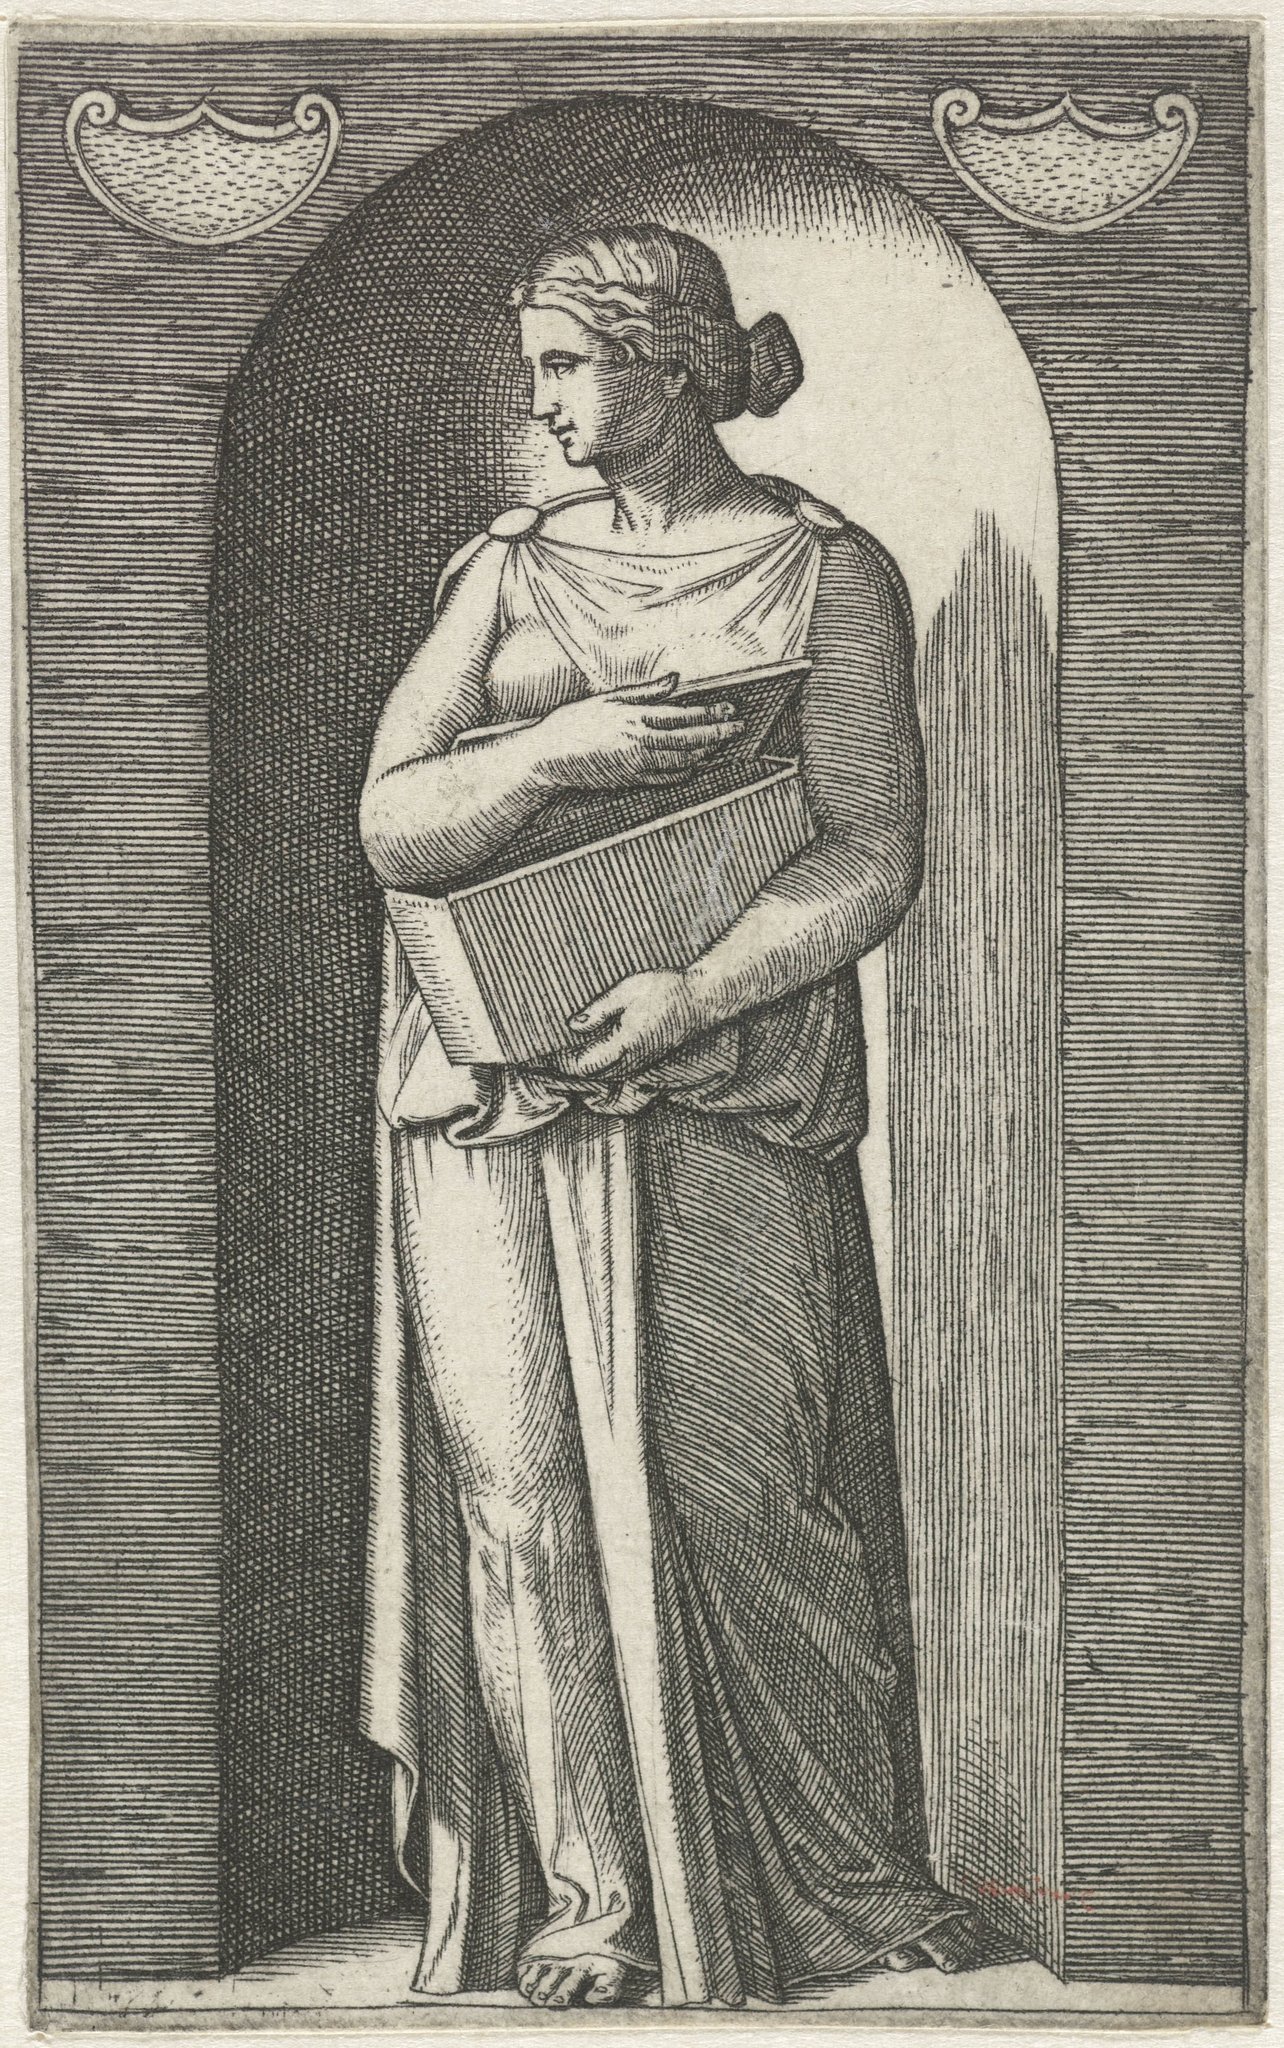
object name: print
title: Goden en muzen en jonge vrouwen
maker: marcantonio raimondi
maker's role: print maker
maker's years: 1470-1534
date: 1511-1520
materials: paper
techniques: engraving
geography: italy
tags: (story of the) muses; 'muse' (ripa)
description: Prent maakt deel uit van serie van zestien prenten met Apollo, Minerva, muzen en andere vrouwen naar ontwerp van Raphael. De verschillende muzen zijn lastig van elkaar te onderscheiden.